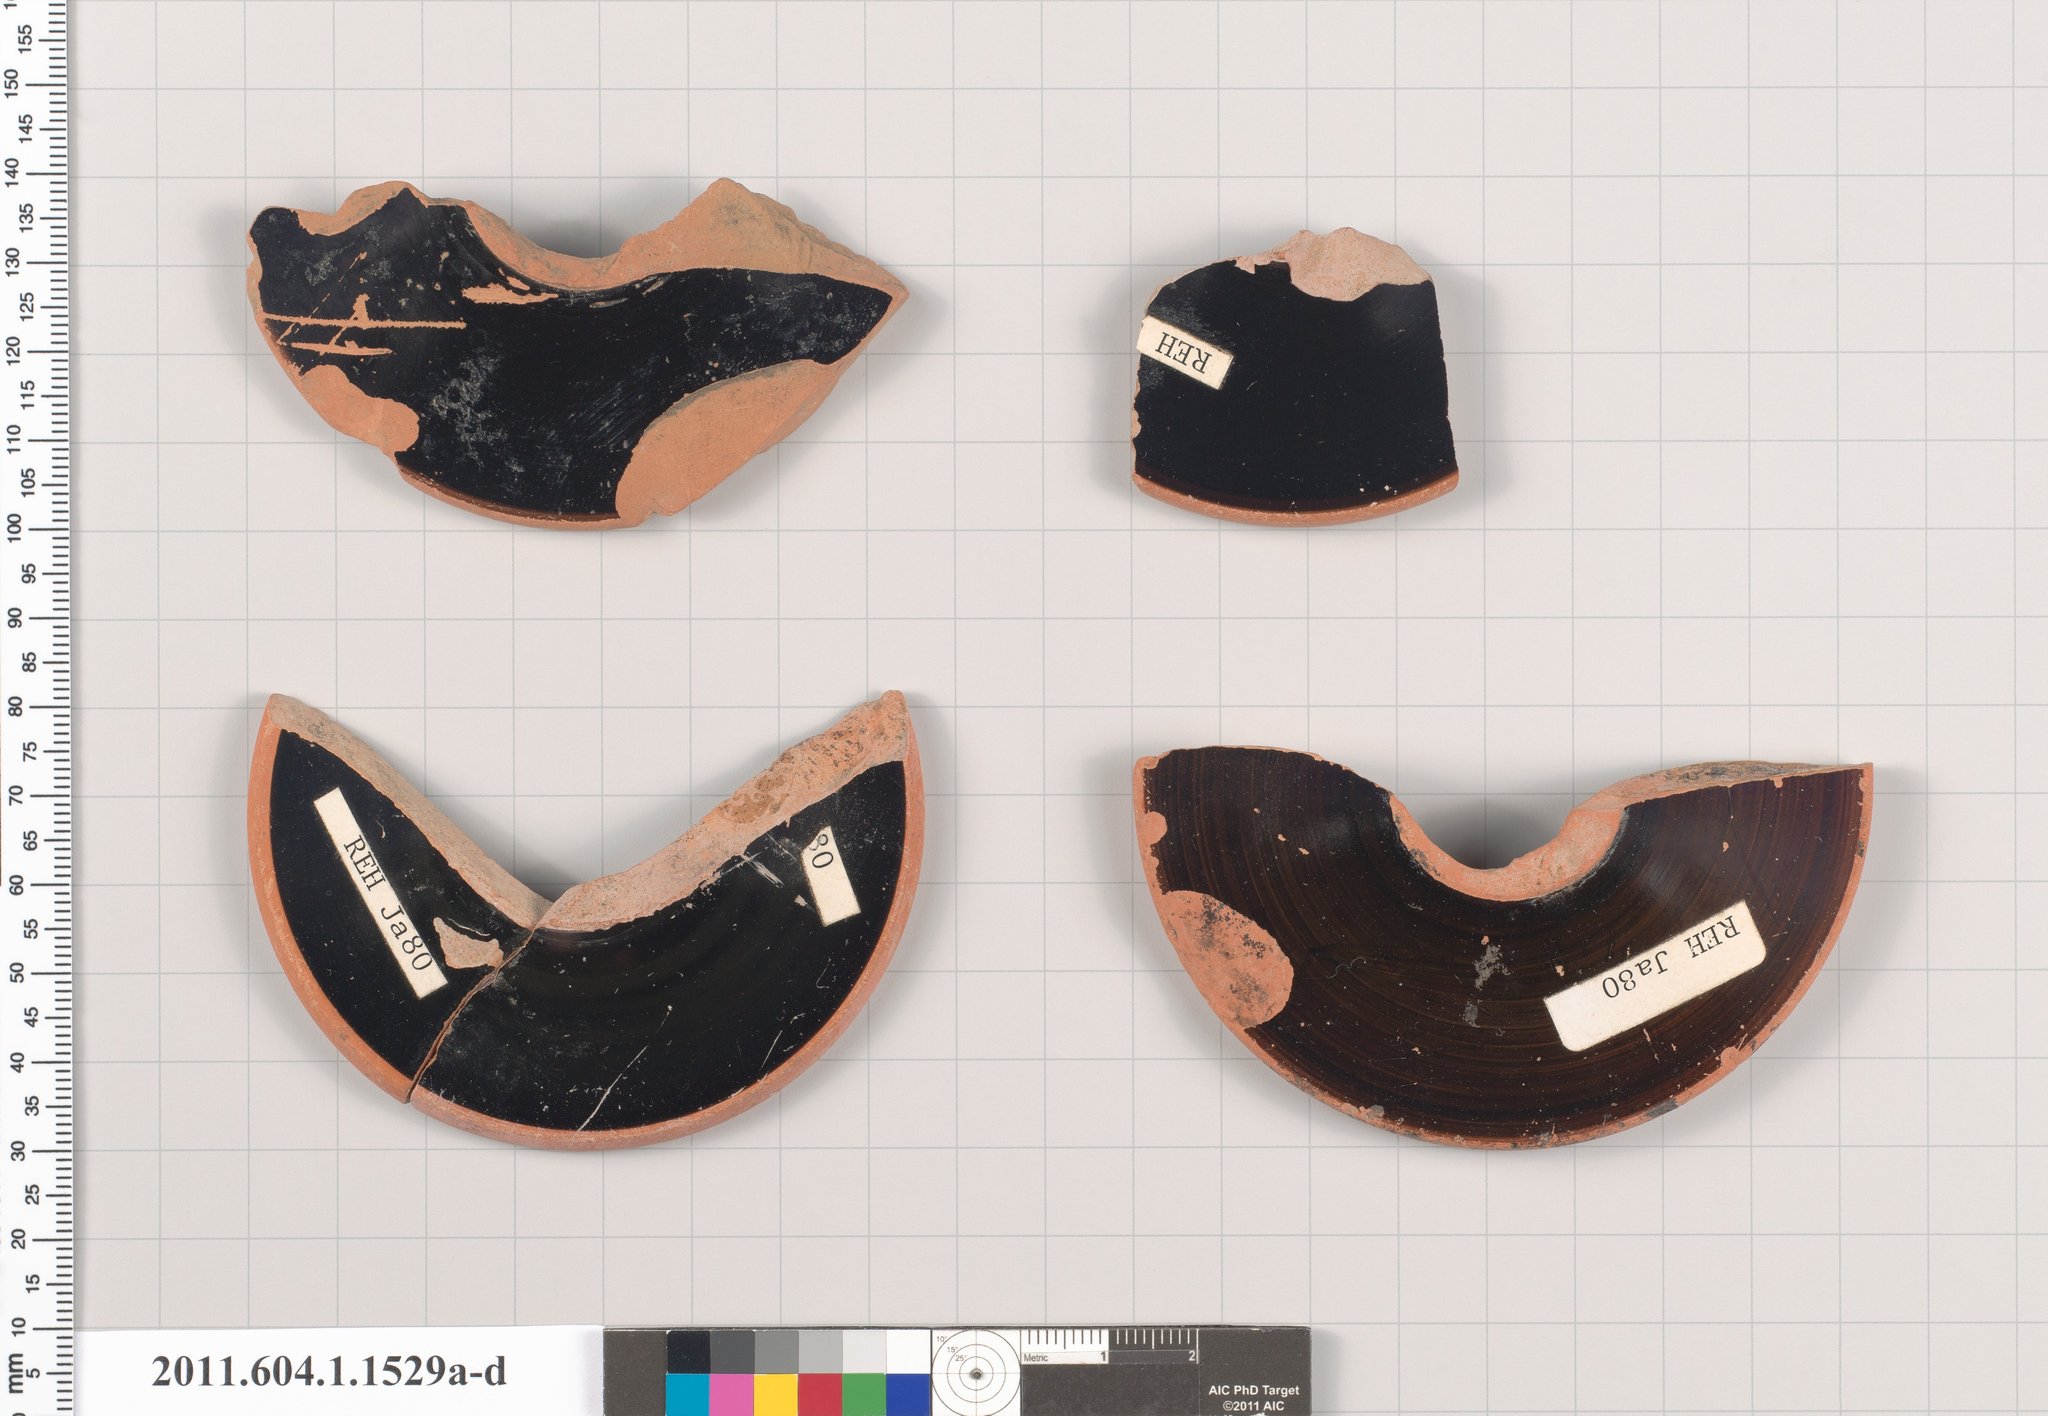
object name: kylix fragment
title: Terracotta fragments of kylikes (drinking cups)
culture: greek, attic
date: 500-401 BCE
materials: terracotta